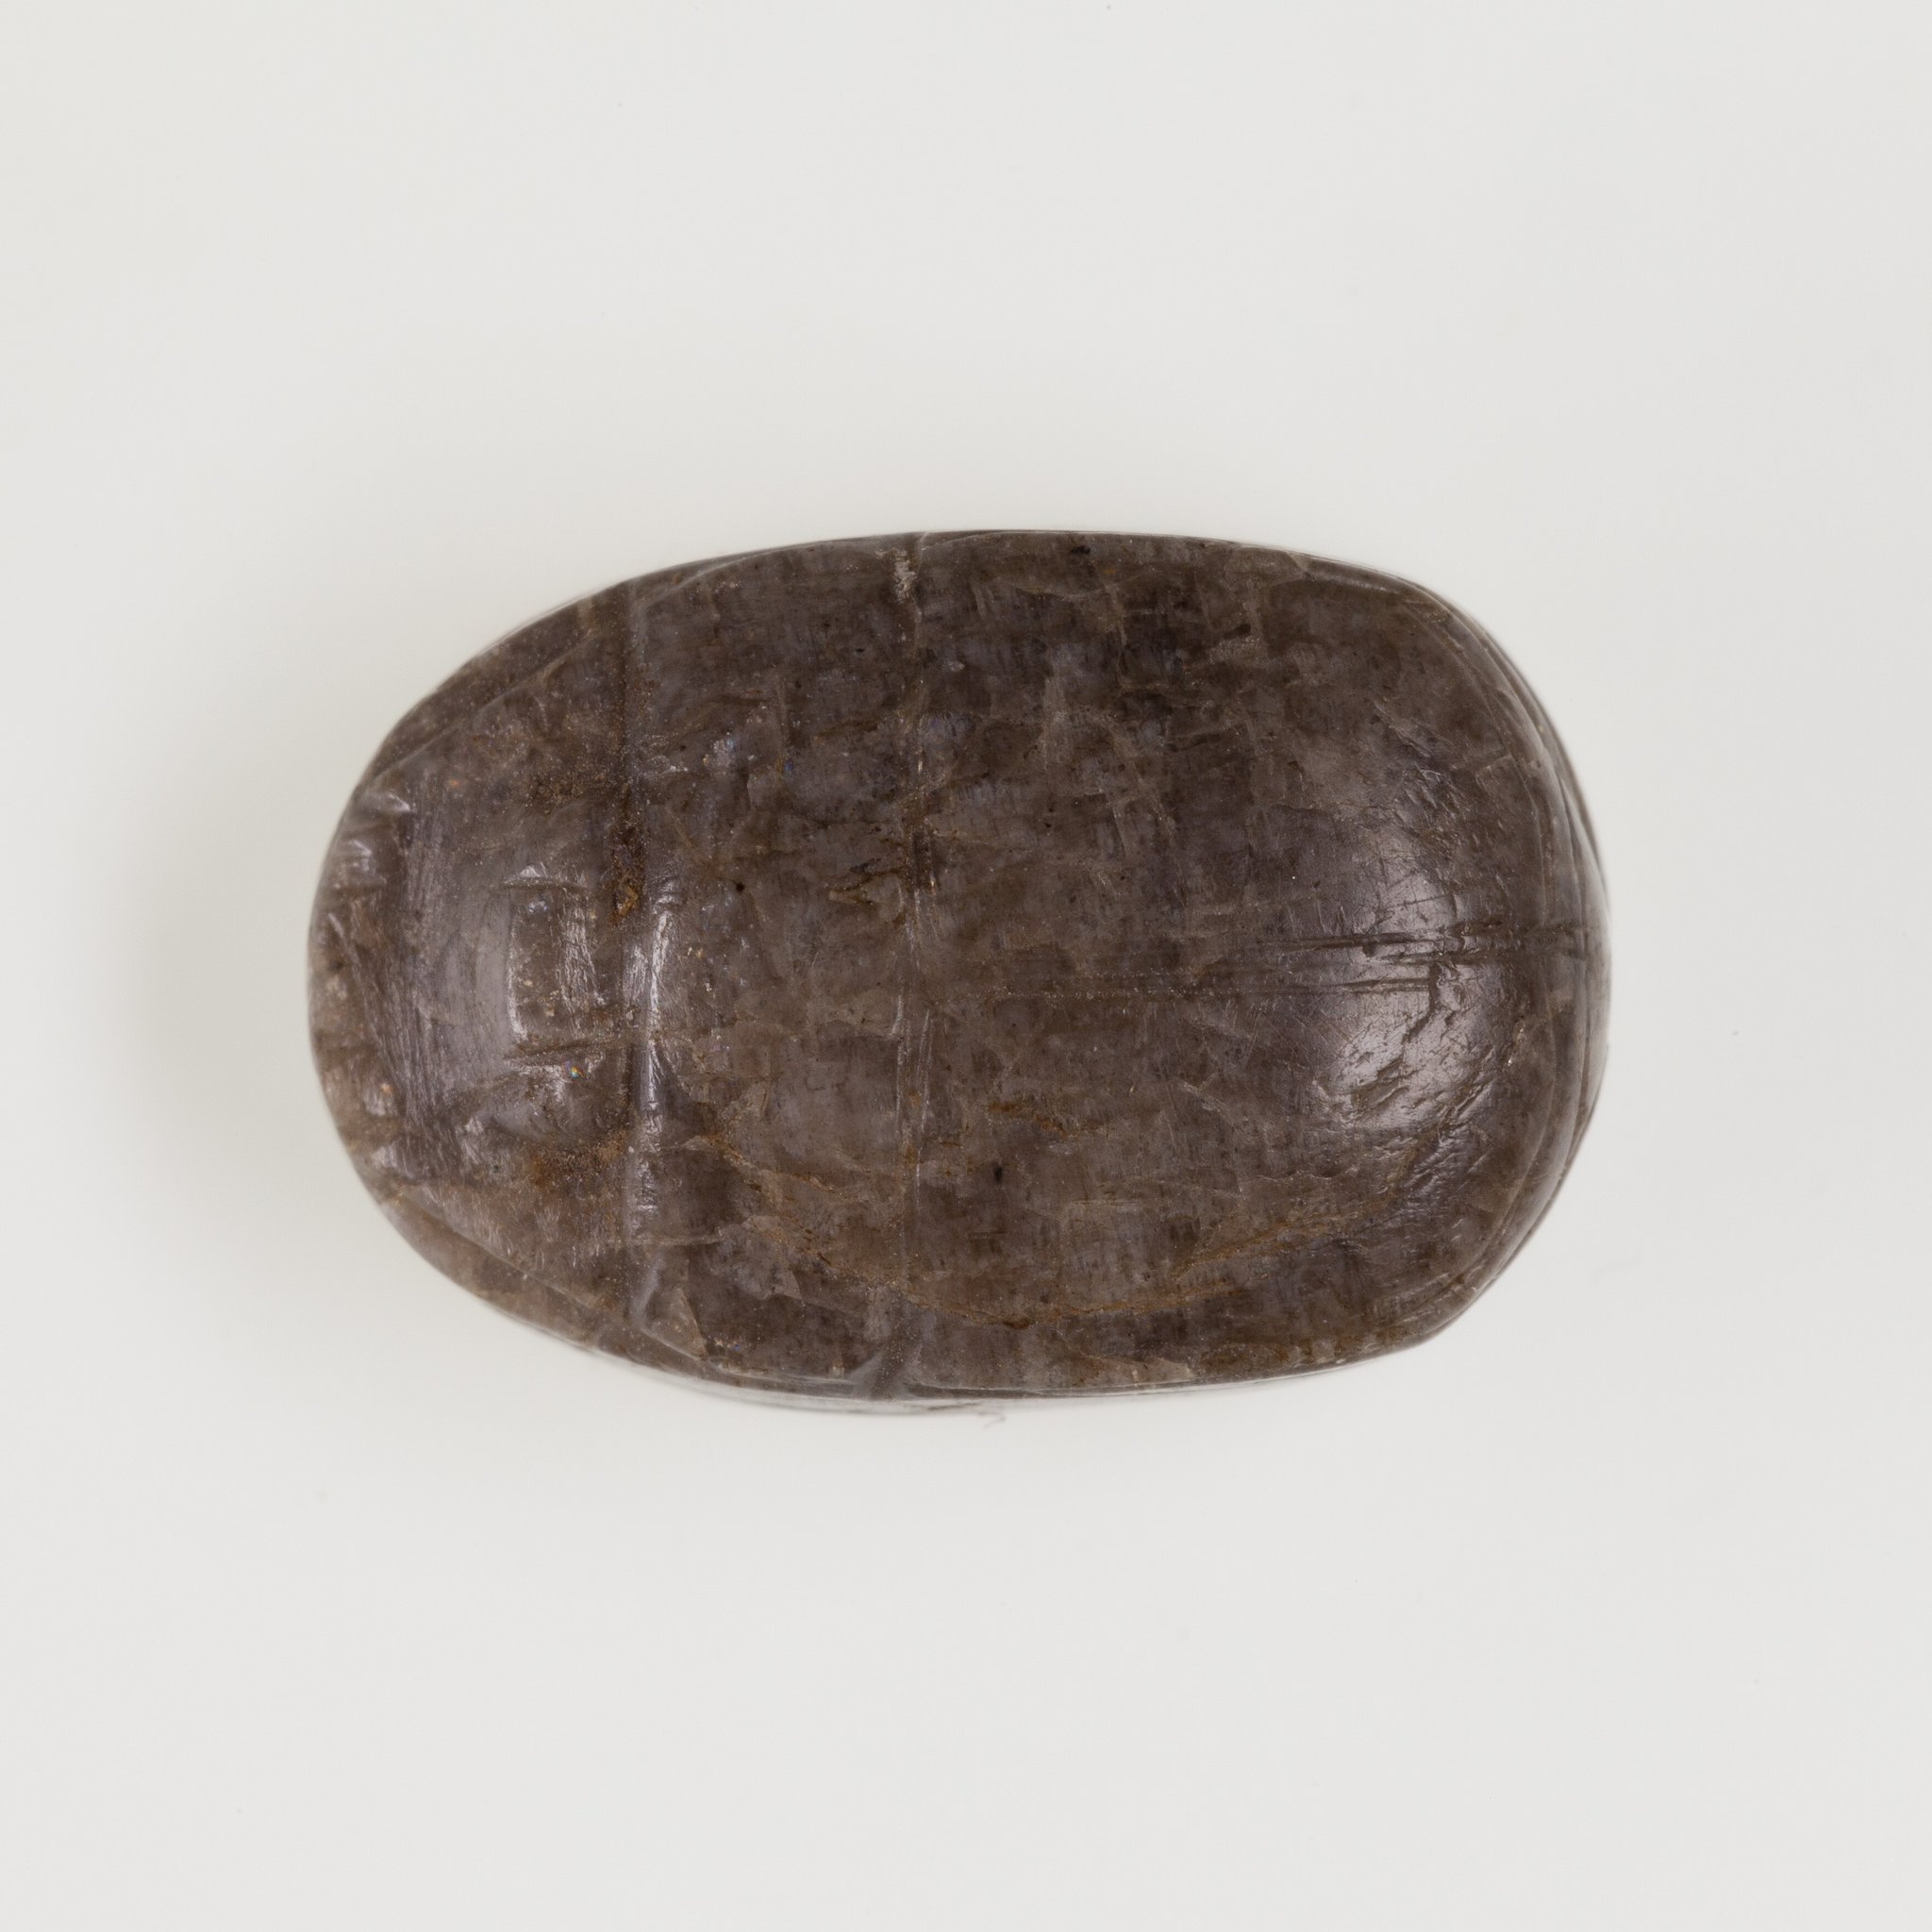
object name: scarab, uninscribed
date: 1981-1550 BCE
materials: stone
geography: egypt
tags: scarabs